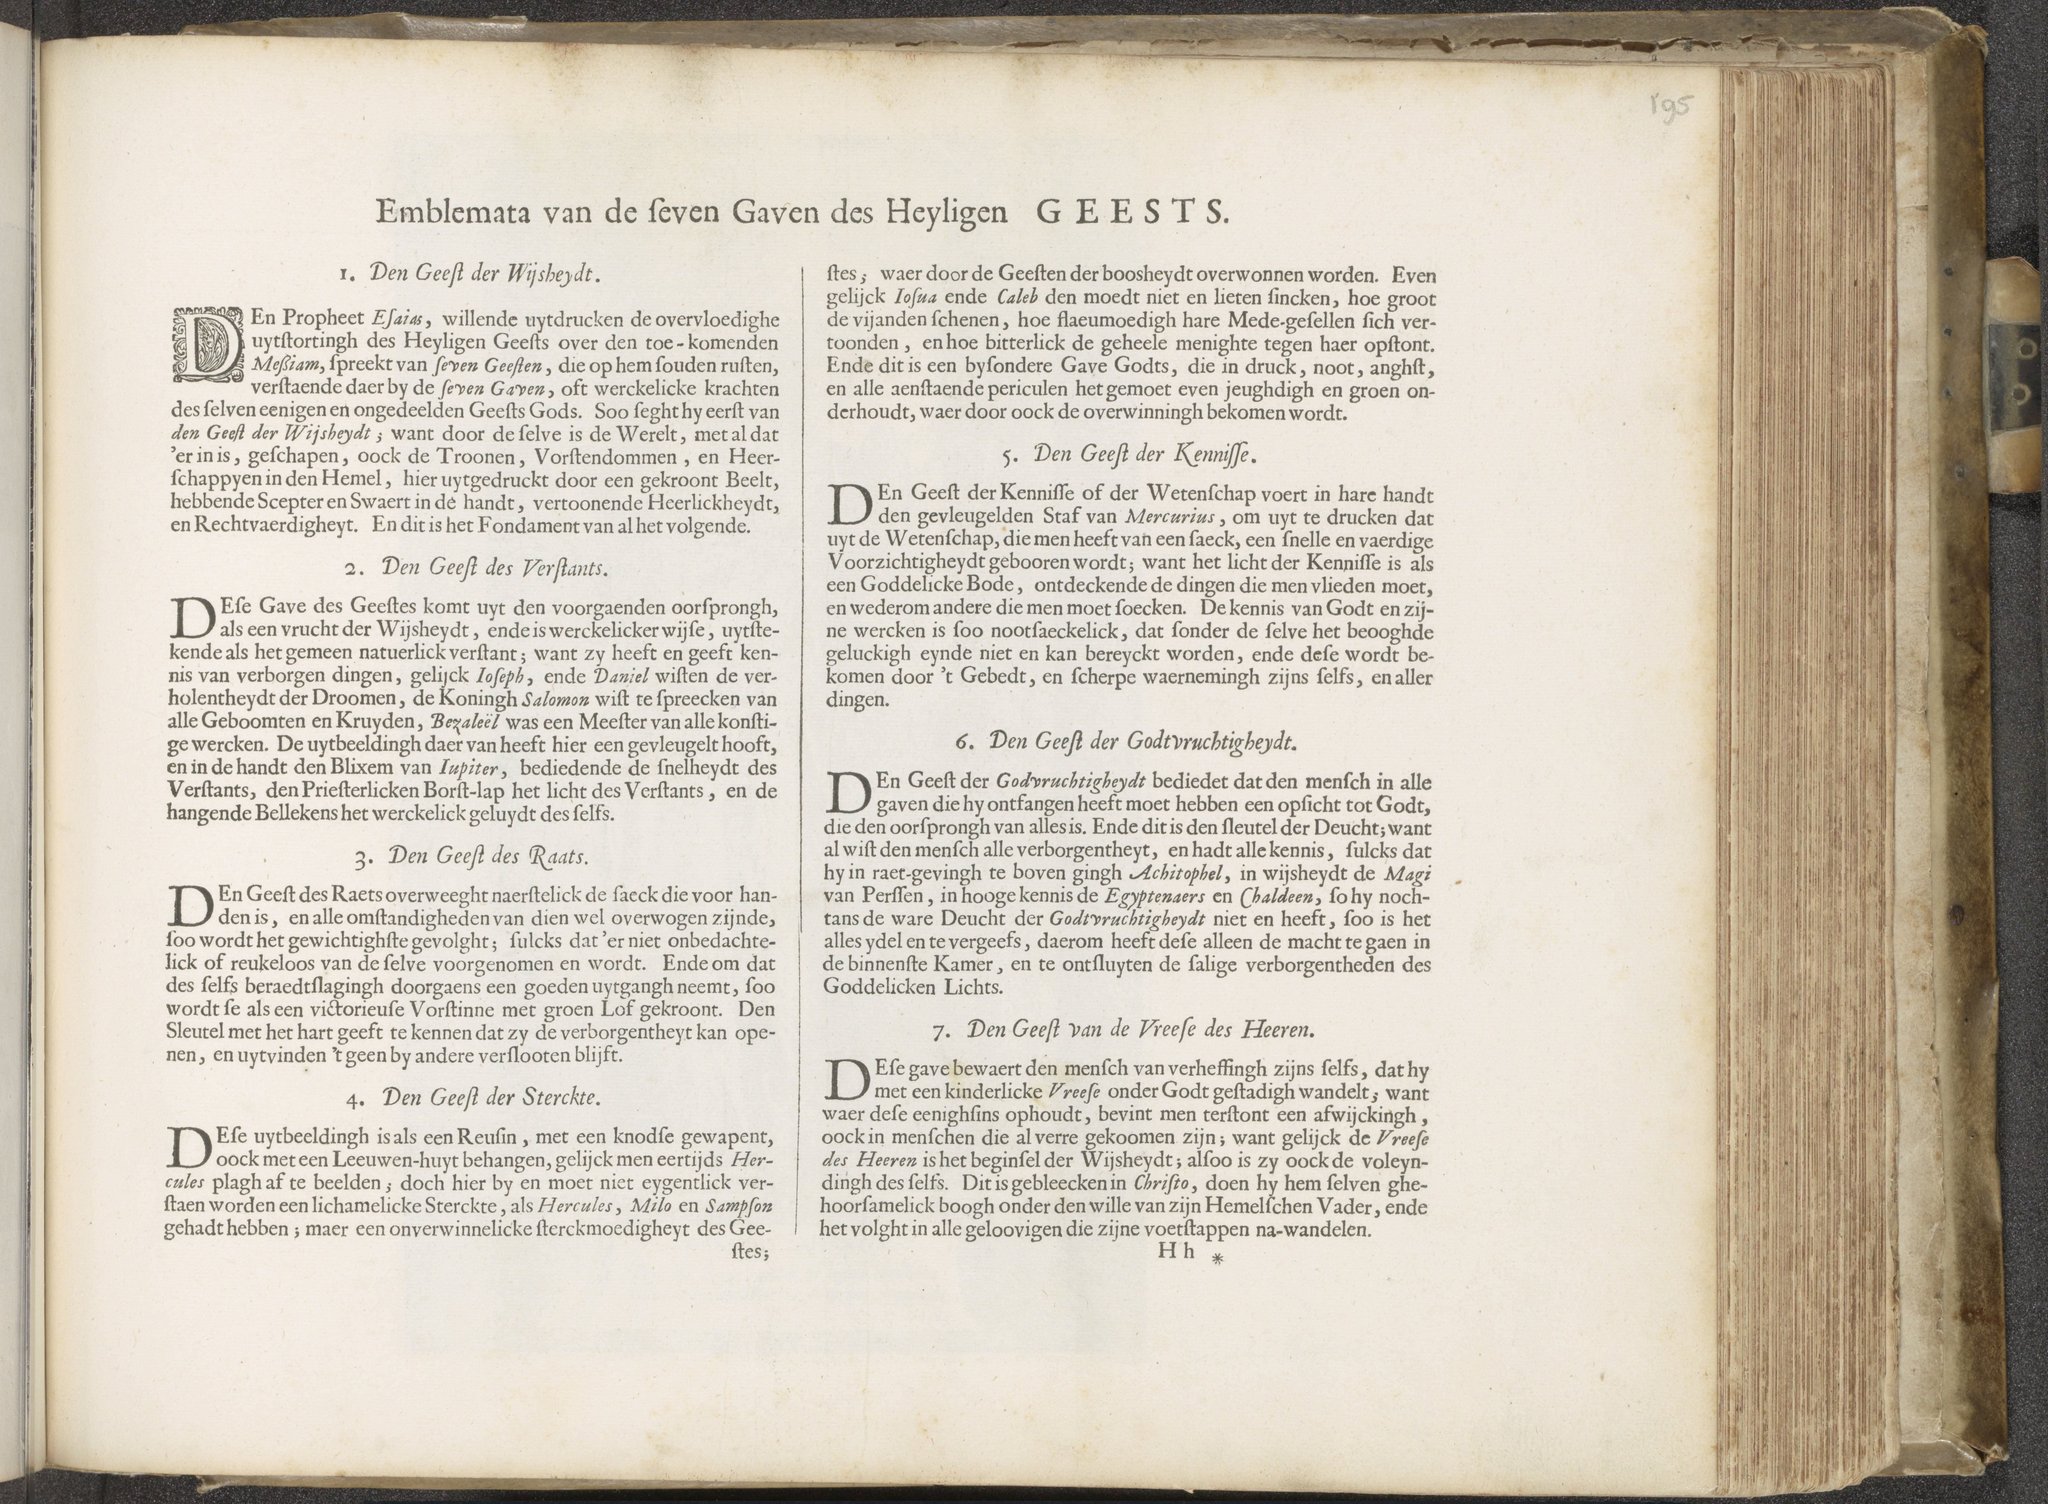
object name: text sheet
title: Toelichtingen bij voorstellingen over de zeven gaven van de Heilige Geest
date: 1653-1654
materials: paper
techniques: letterpress printing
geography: amsterdam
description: Toelichtingen bij voorstellingen over de zeven gaven van de Heilige Geest, genummerd een tot en met zeven: wijsheid, verstand, raad, sterkte, wetenschap, godsvrucht en vreze des Heren. De tekst vangt aan met een kleine gedecoreerde initiaal D. Het blad maakt deel uit van een album.